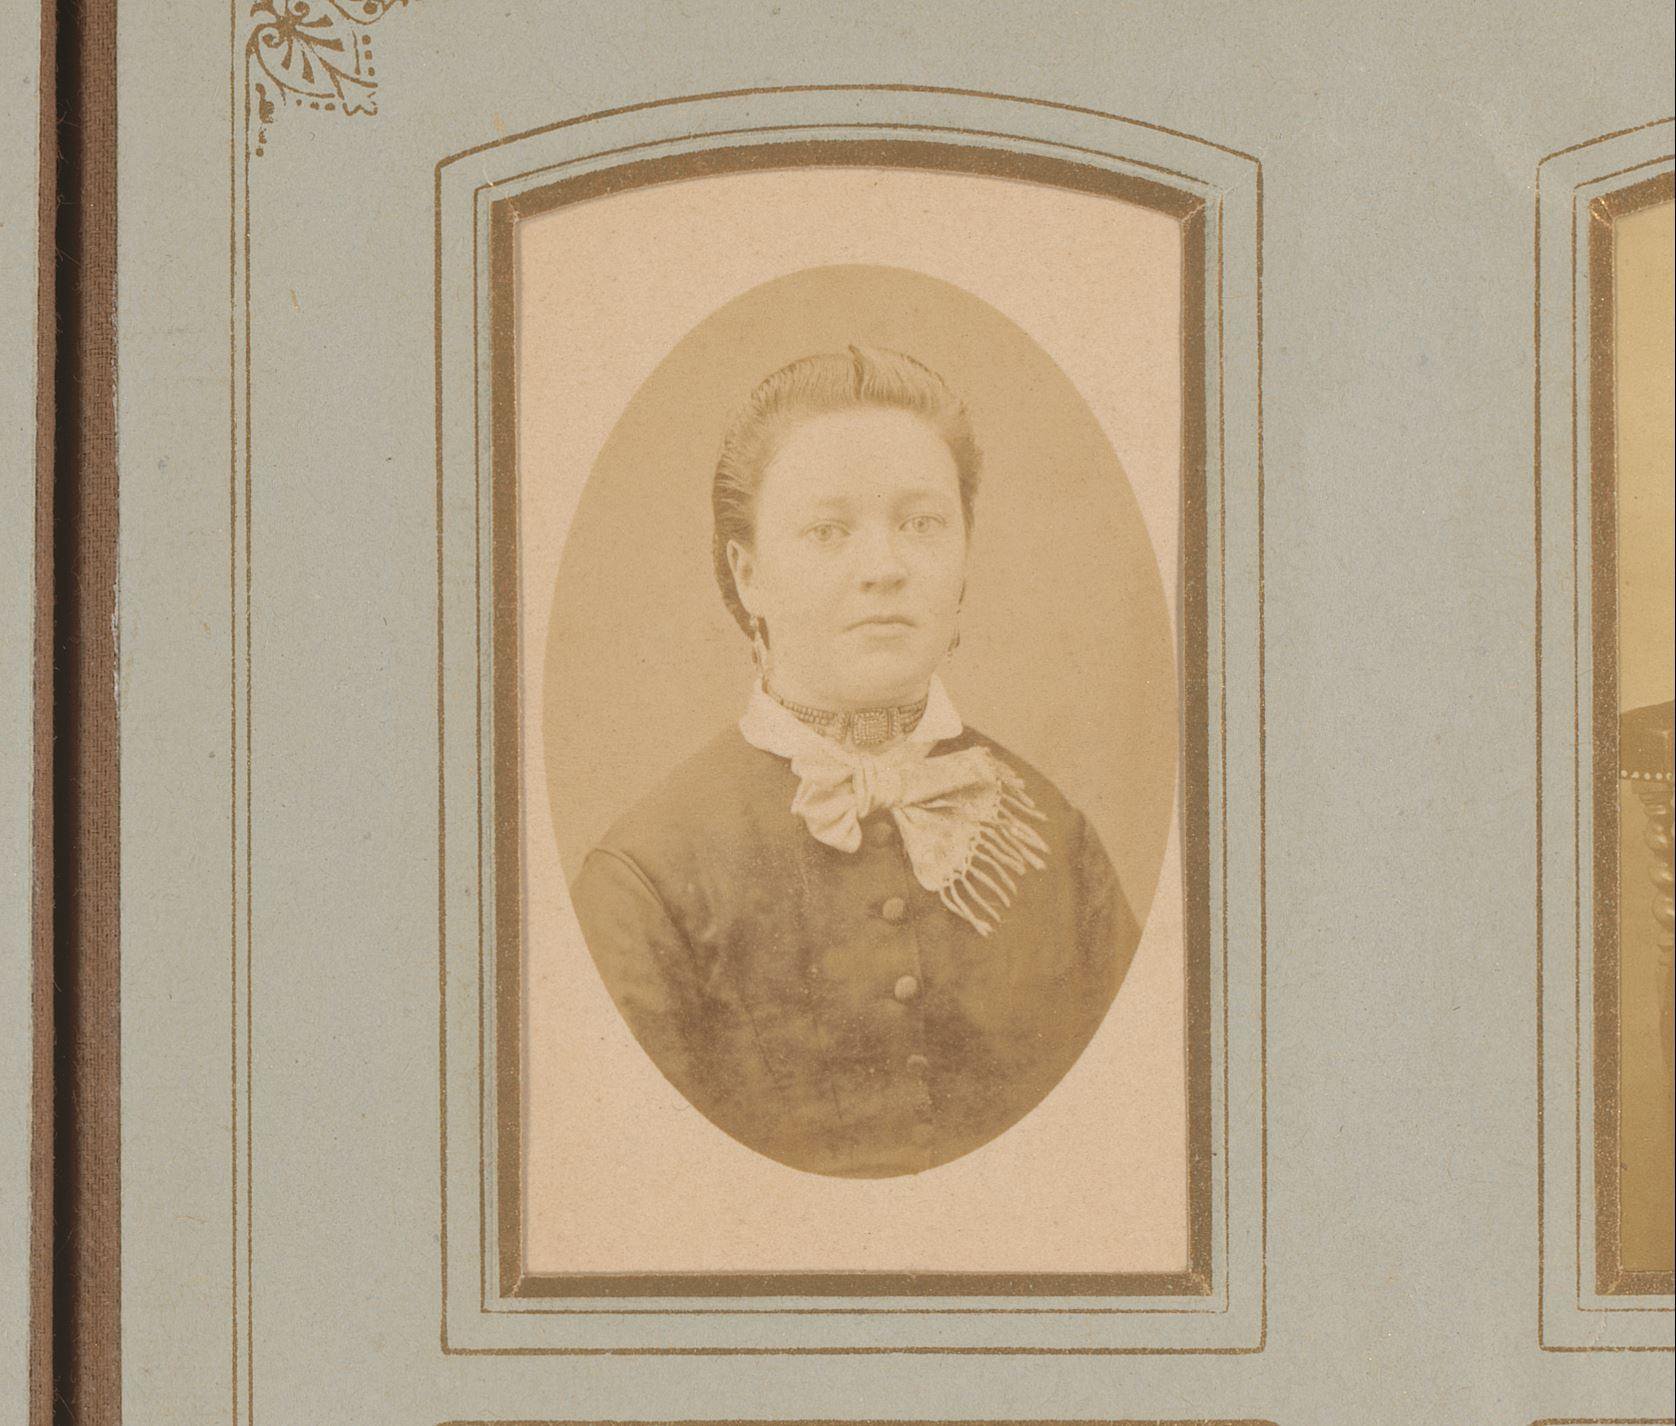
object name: carte de visite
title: Portret van een vrouw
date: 1857-1894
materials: cardboard, photographic support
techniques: albumen print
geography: edam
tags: historical persons - bb - woman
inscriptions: inscription: ‘P. SIEWERS en ZOON/ Photograph:/ ATELIER/ EDAM/ Voorhaven/ HILVERSUM/ Badhuis./ Te Edam dagelyks werkzaam./ Te Hilversum Zondags en maandags./ De Plaats wordt voor Nabestelling/ bewaard.’